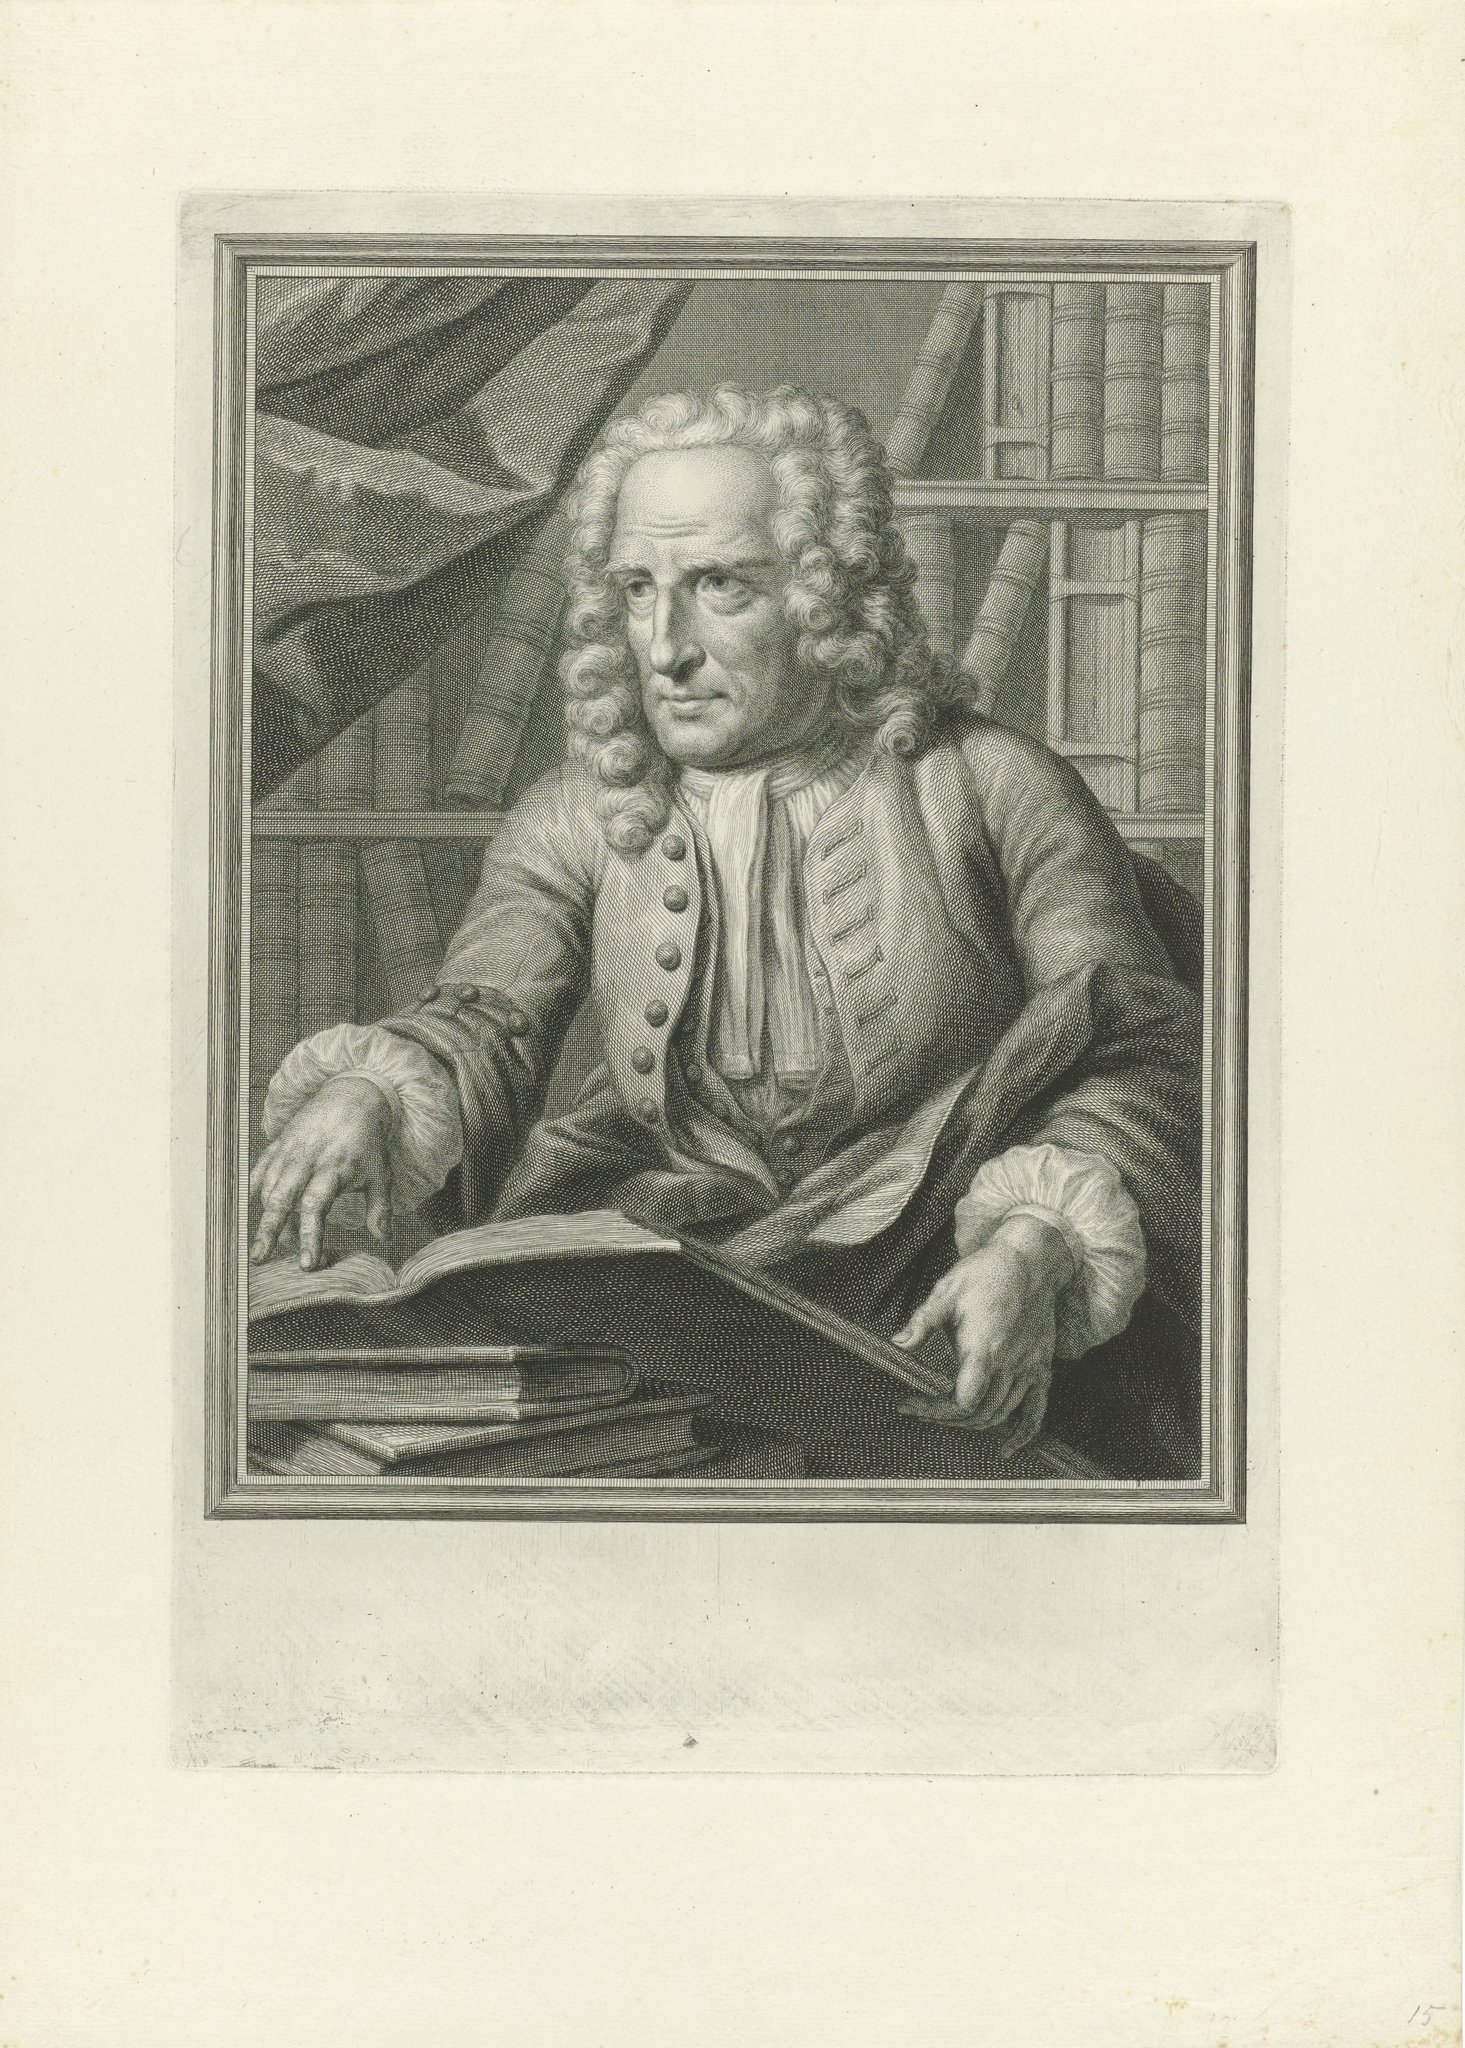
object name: print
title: Portret van François Fagel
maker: pieter tanjé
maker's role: draughtsman, print maker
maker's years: 1706-1761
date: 1747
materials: paper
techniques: engraving, etching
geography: amsterdam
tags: the hague, book - mm - book open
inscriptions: collector's mark: Lugt 240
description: Portret van François Fagel, griffier van de Staten Generaal, met een opengeslagen boek in zijn handen. Op de achtergrond een boekenkast.